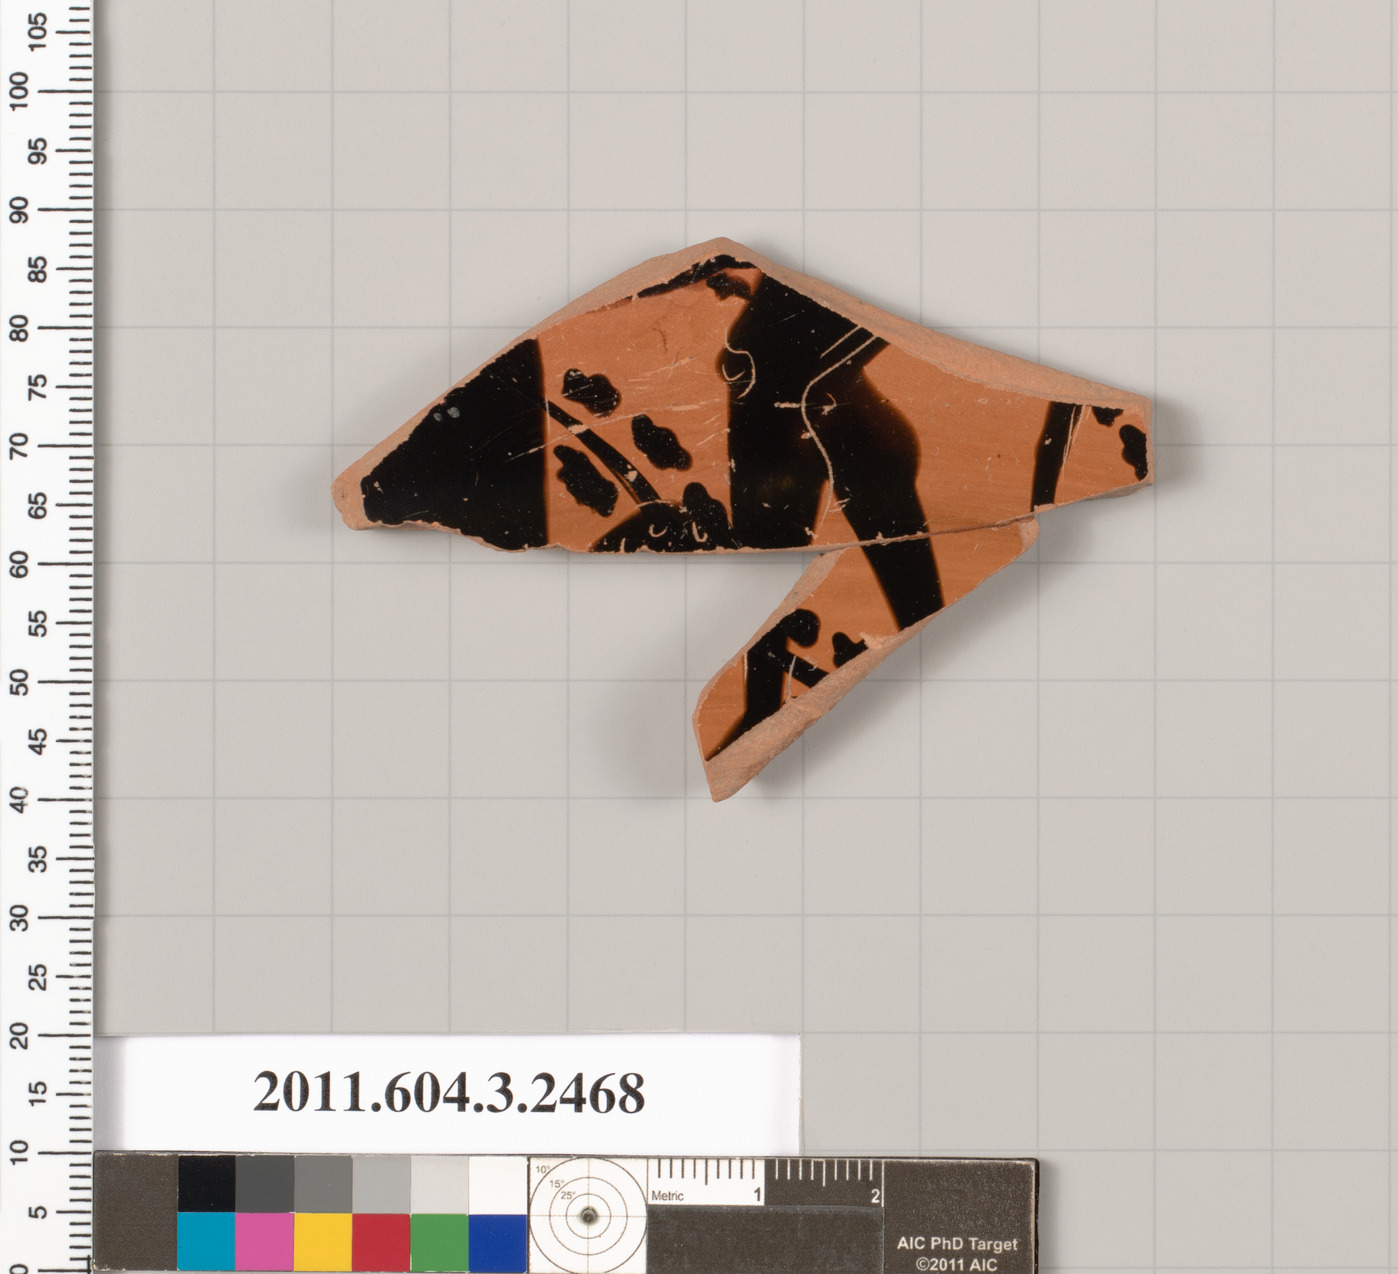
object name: kylix fragment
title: Terracotta fragment of a kylix: eye-cup (drinking cup)?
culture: greek, attic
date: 520-510 BCE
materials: terracotta